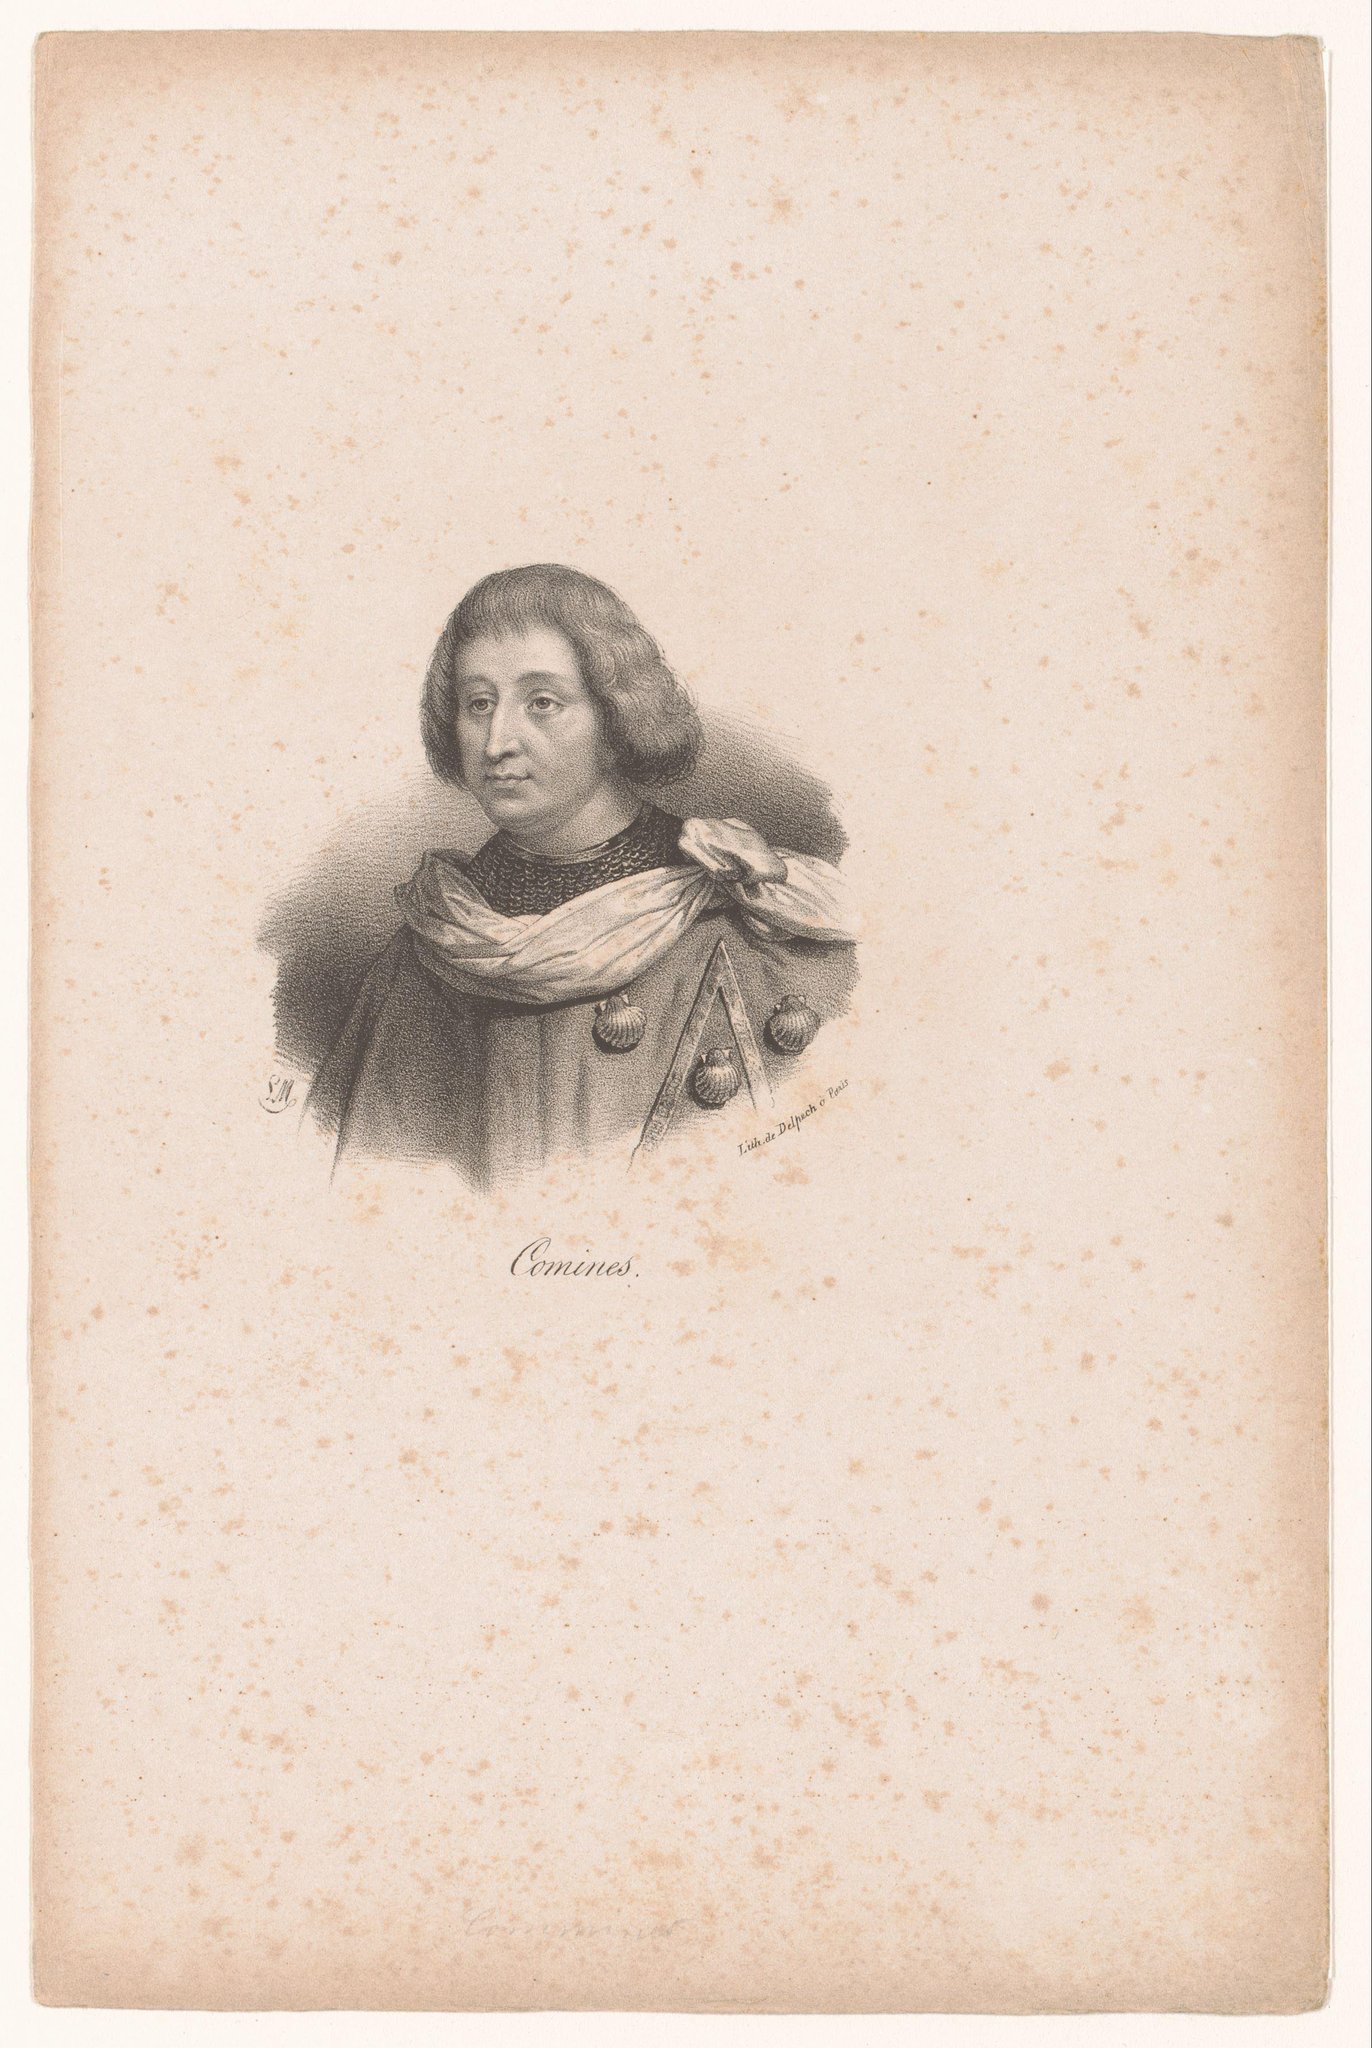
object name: print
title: Comines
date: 1825-1842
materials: paper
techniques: lithograph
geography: paris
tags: historical persons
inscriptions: collector's mark: Lugt 2228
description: Prent waarschijnlijk gebruikt voor: Iconographie française ou recueil des portraits des personnages les plus illustres qui ont paru en France depuis François premier jusqu'à la fin du règne de Louis XVI (…). Parijs: veuve Delpech, 1828. En/of voor: Iconographie française ou choix de deux cents portraits d'hommes et de femmes qui se sont acquis en France, depuis le règne de Charles VII jusqu'à la fin de celui de Louis XVI (…). Parijs: veuve Delpech, 1840. Mogelijk komt de prent ook voor in eerdere en/of latere publicaties uitgegeven door veuve Delpech of haar opvolger Rosselin.